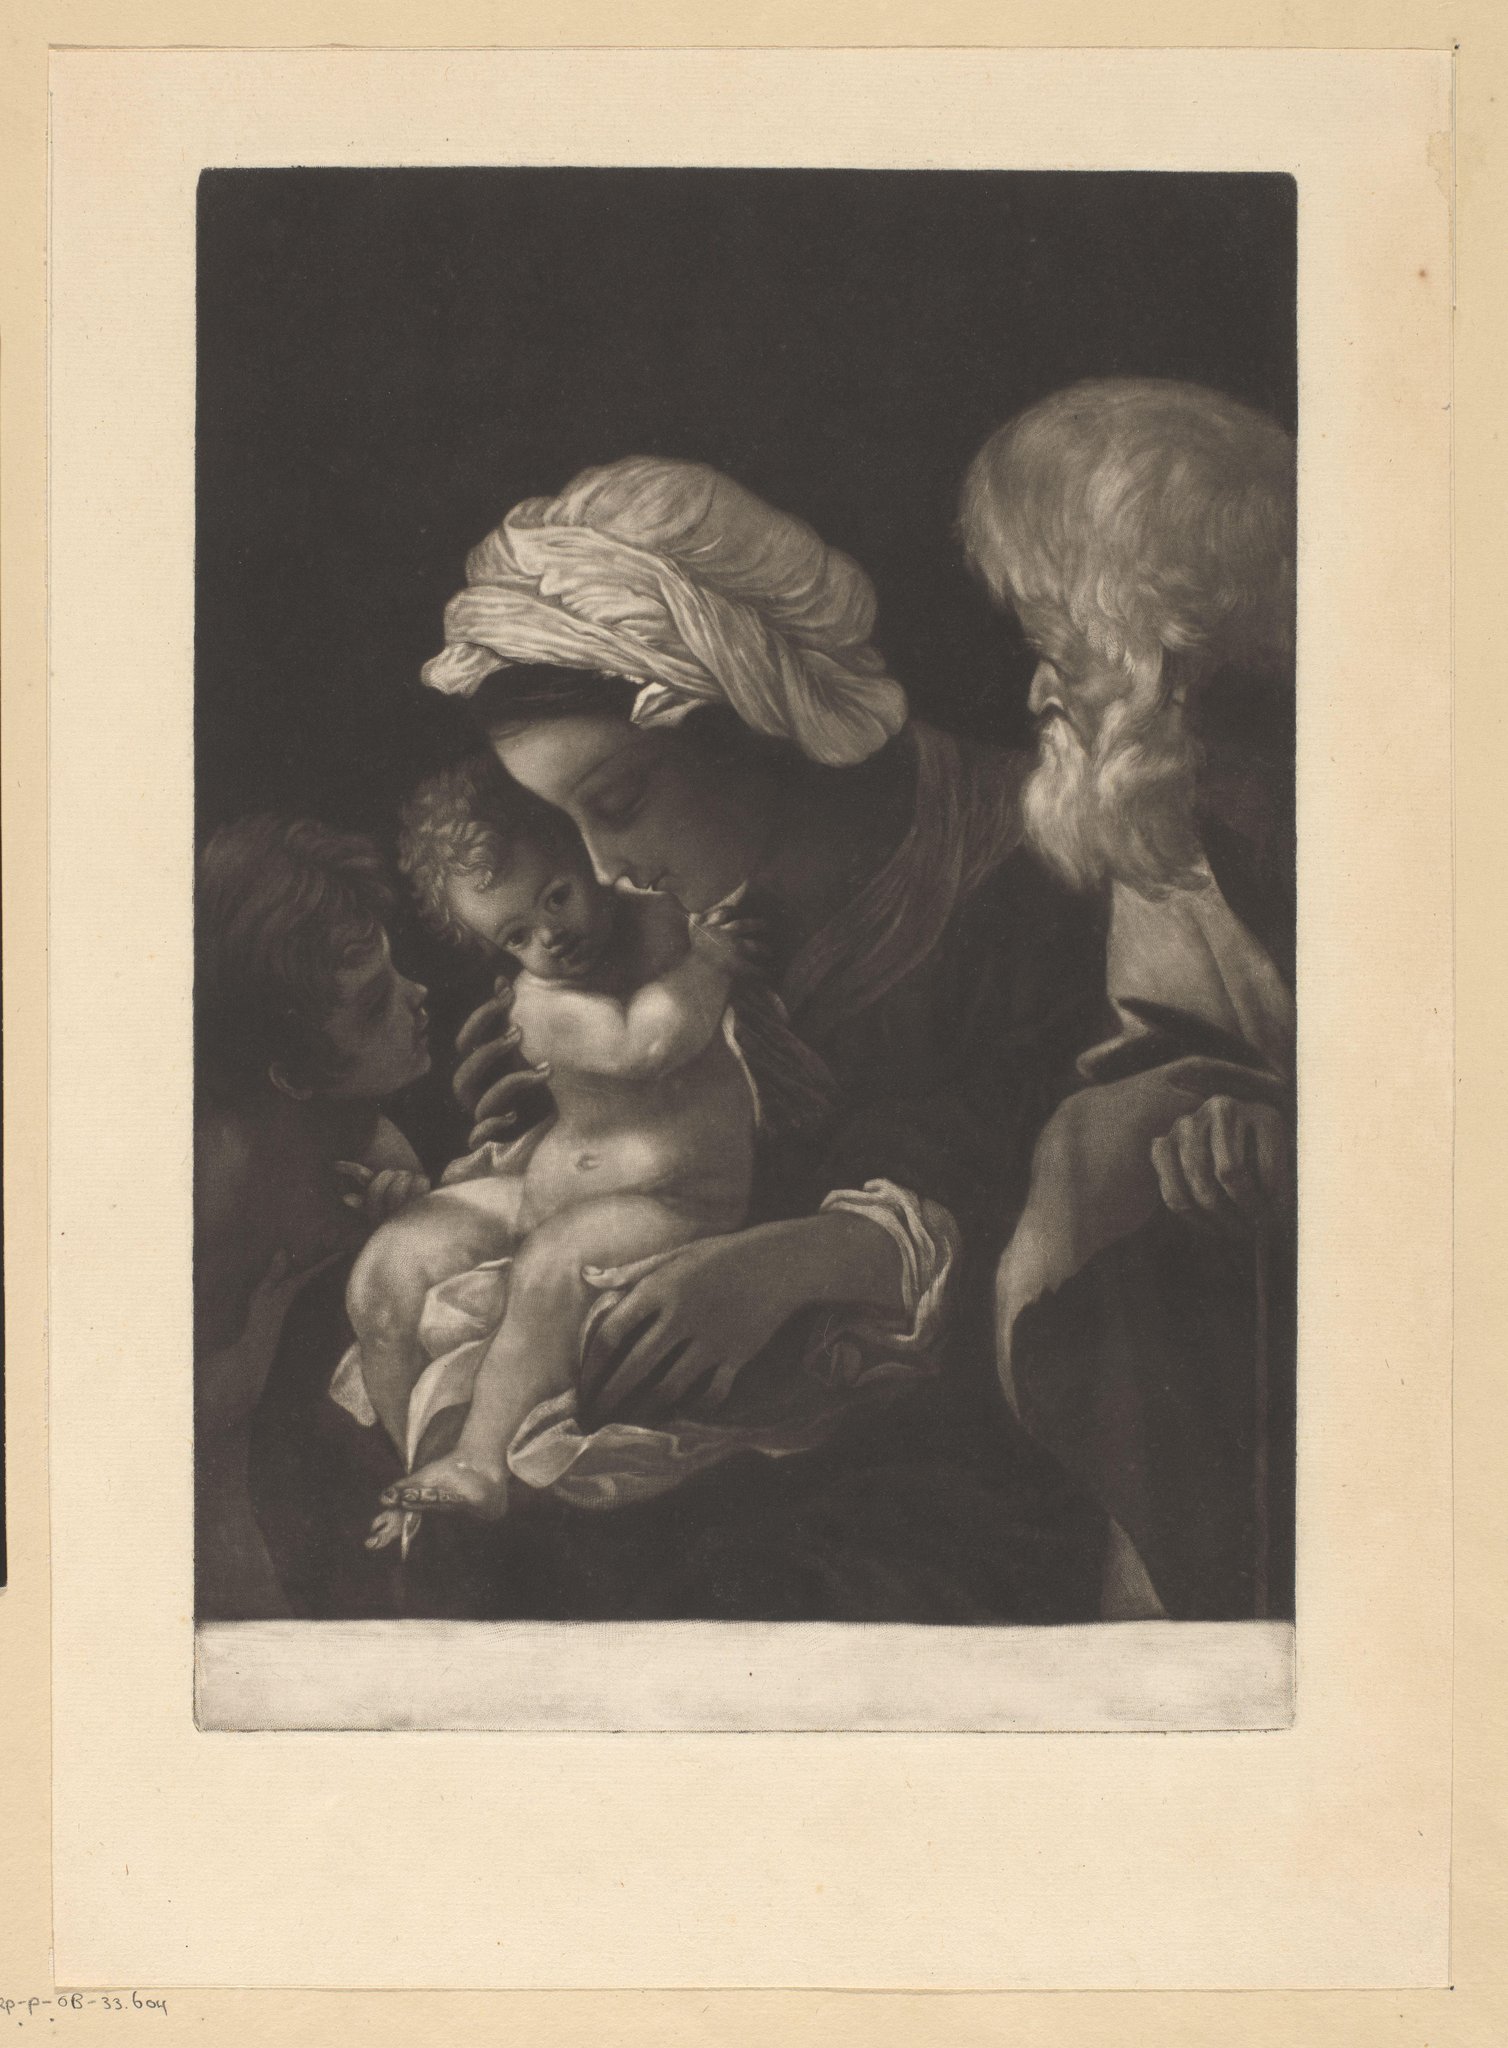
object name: print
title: Heilige Familie met het kind Johannes de Doper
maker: william baillie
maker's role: print maker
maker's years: 1723-1810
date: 1760-1790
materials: paper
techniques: mezzotint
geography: england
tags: holy family with john the baptist (as child)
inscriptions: collector's mark: Lugt 240